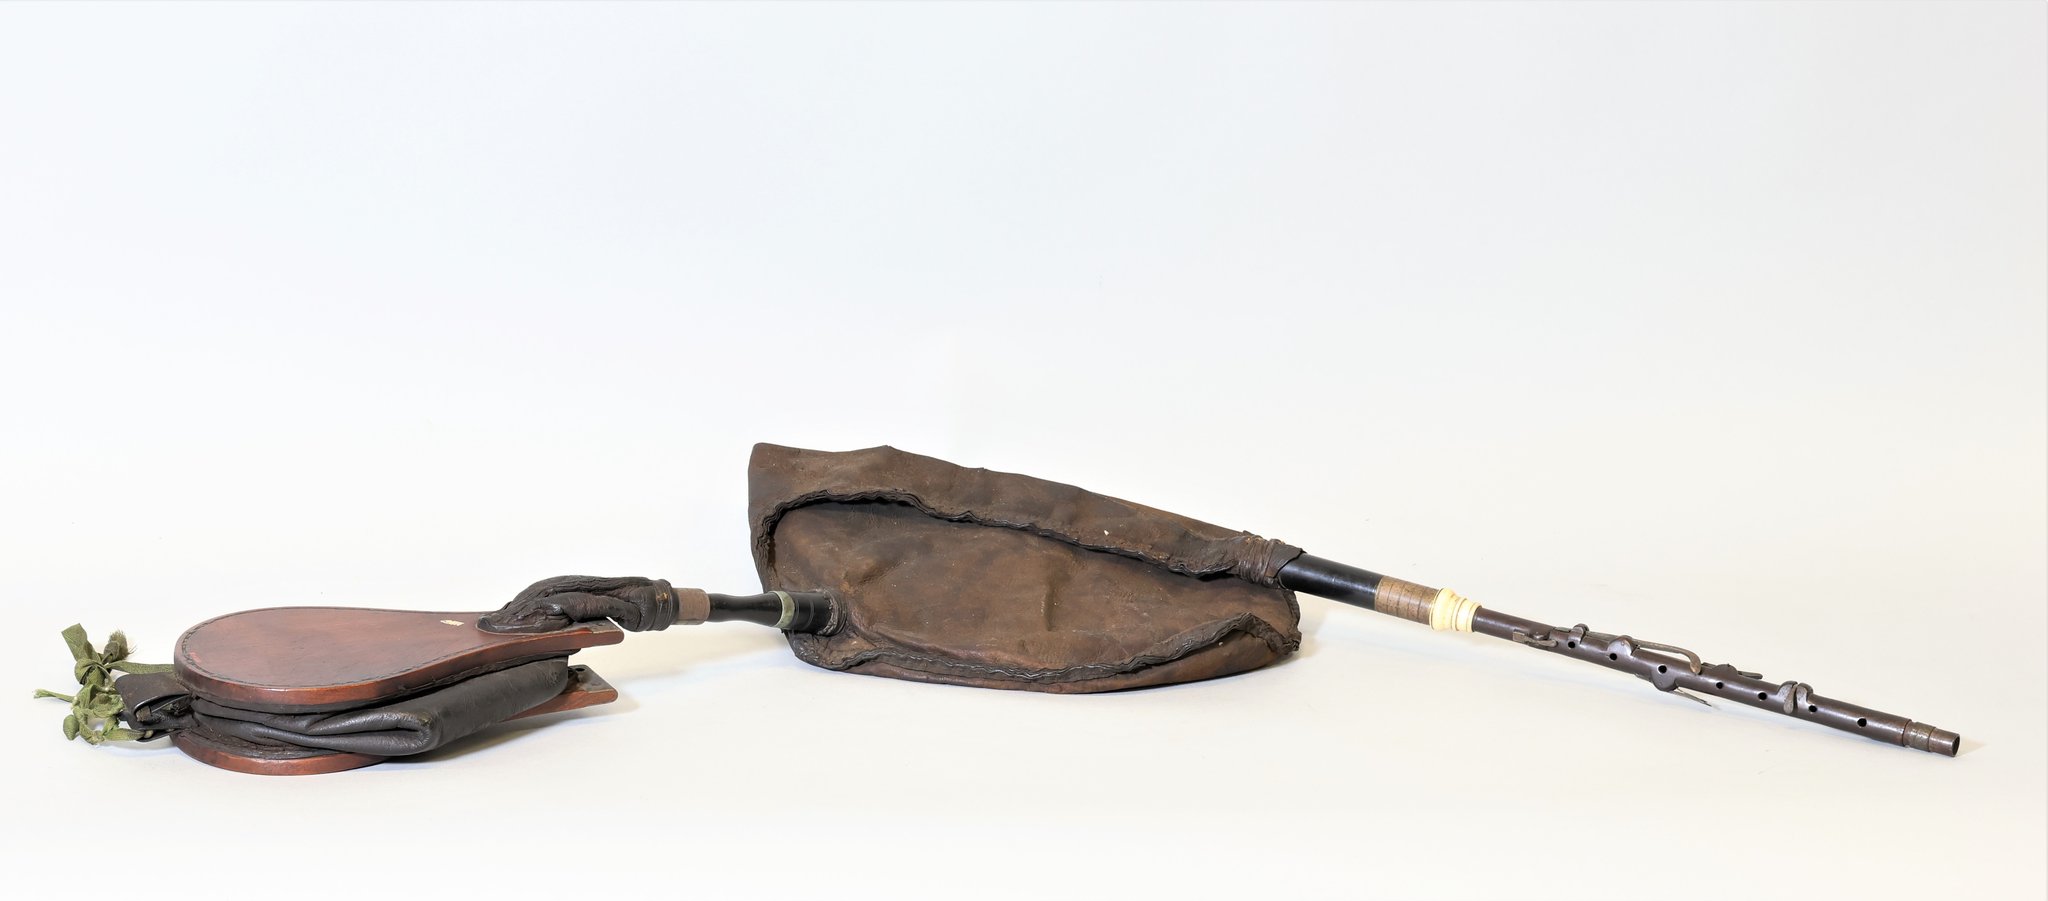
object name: uilleann pipe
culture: irish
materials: brass, ivory, leather, wood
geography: ireland